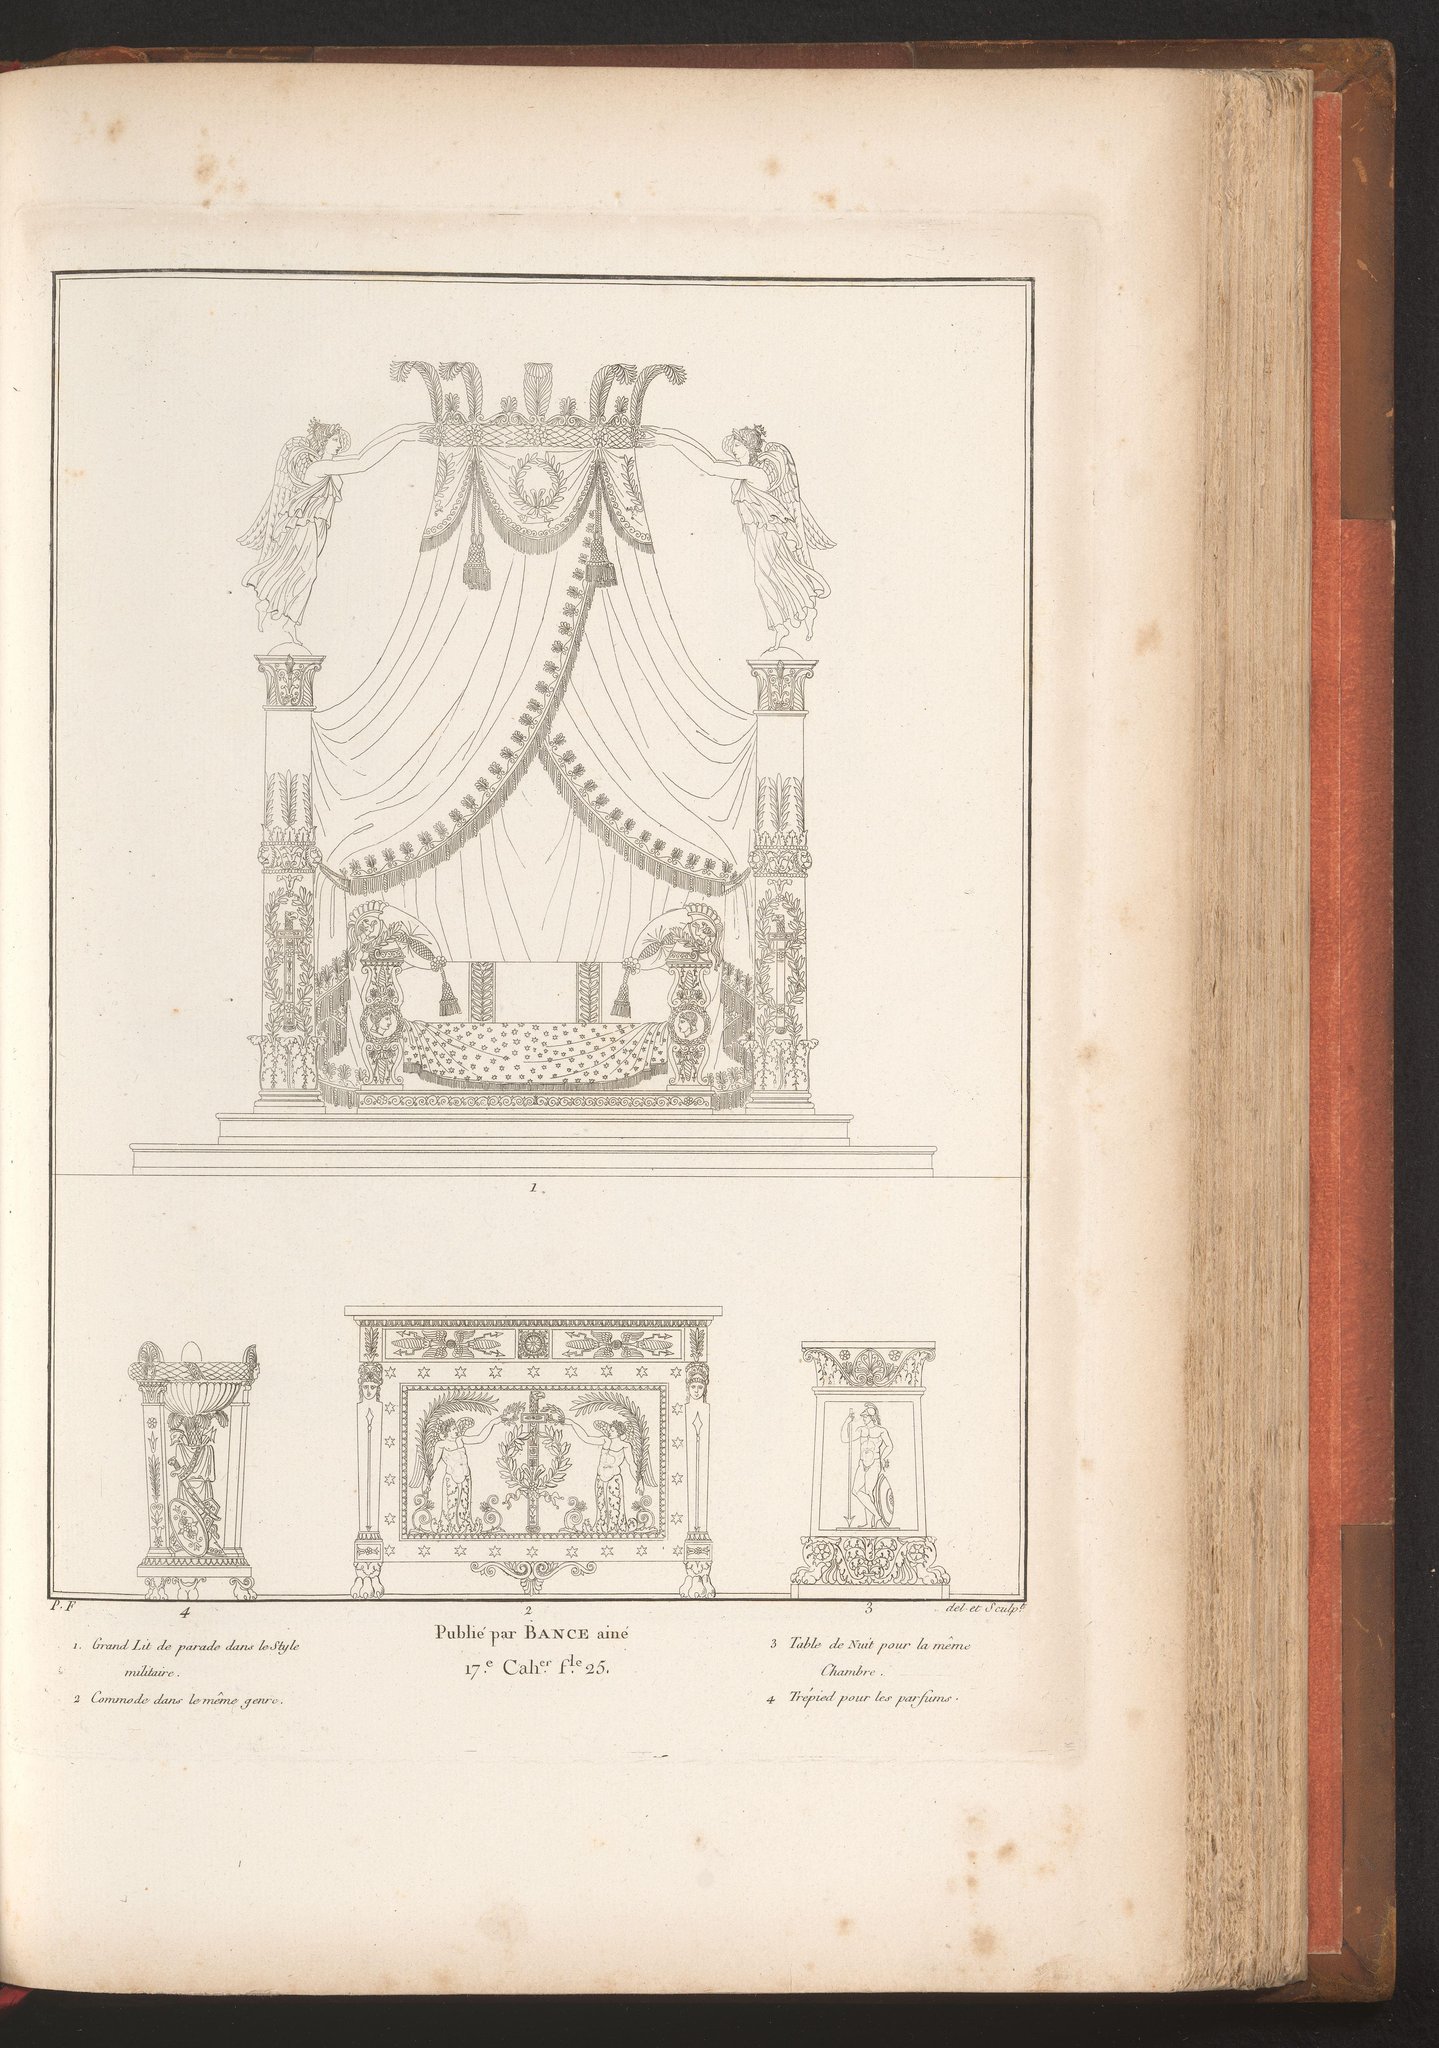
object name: ornament print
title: Hemelbed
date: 1820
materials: paper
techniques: etching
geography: paris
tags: decorative furniture, ornaments ~ art, four poster bed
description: Ornamentprent met een hemelbed en enkele wandmeubels. Onderdeel (17e. Cah. f.le 25) van het prentalbum met twee series van in totaal 138 ornamentprenten door Beauvallet en Normand, 'Fragmens d'Ornemens dans le Style Antique'.